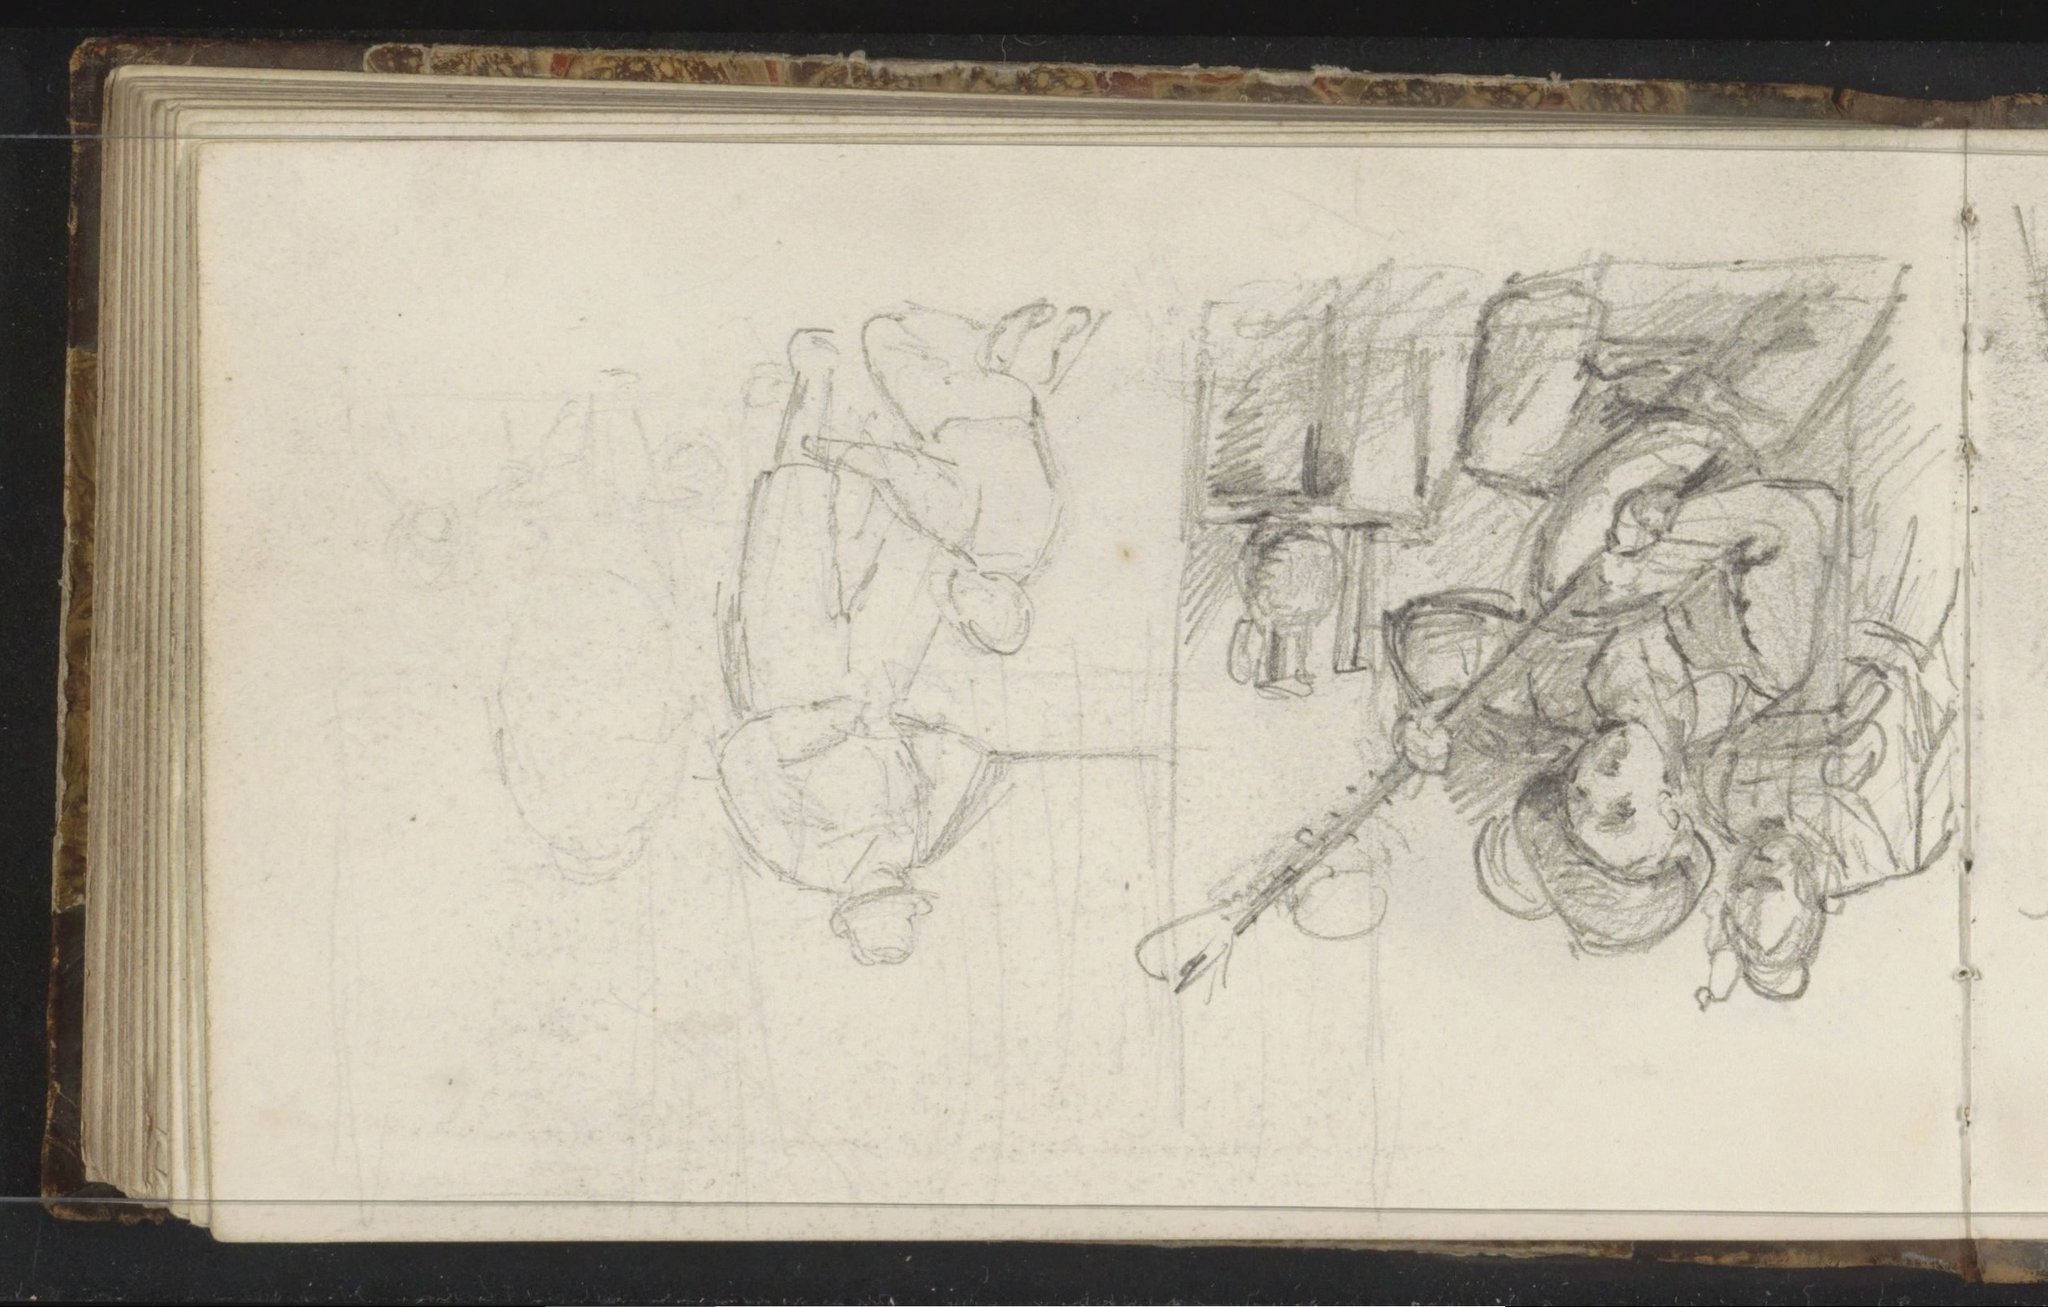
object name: sketchbook leaf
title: Luitspeler en een interieur met figuren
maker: willem hendrik schmidt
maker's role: draughtsman, painter, print maker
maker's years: 1809-1849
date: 1819-1849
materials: paper, pencil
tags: lute, and special forms of lute, e.g.: theorbo (+ artist at work), interior of the house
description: Blad 56 verso uit een schetsboek met 60 bladen.